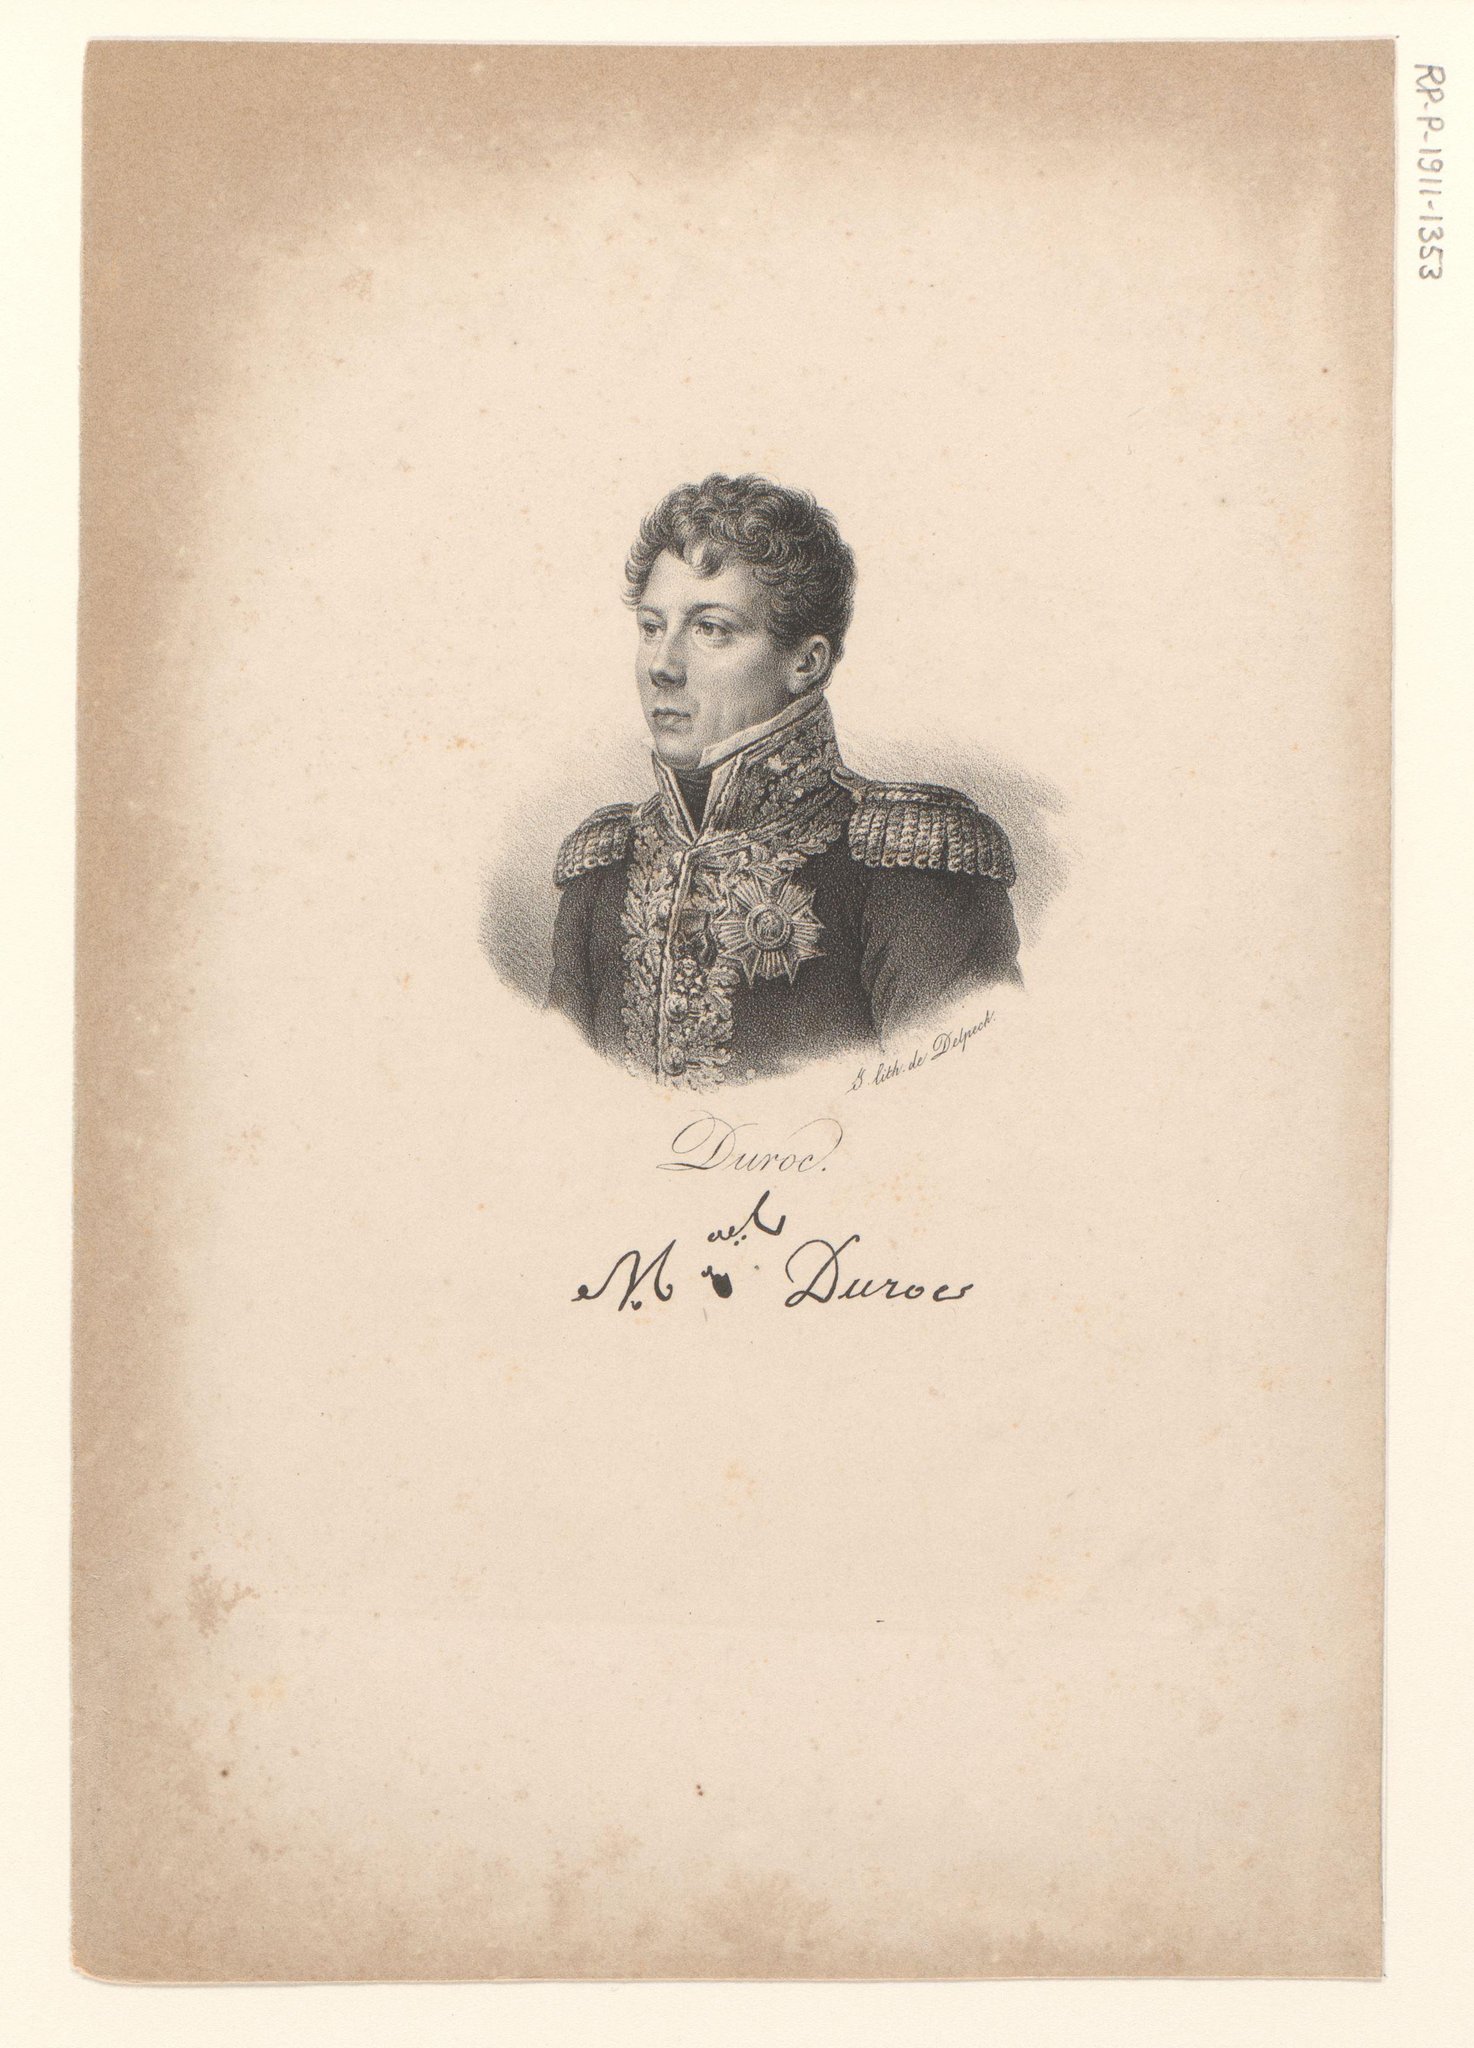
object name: print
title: Portret van Géraud Christophe Michel Duroc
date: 1818-1842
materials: paper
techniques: lithograph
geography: paris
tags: historical persons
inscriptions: collector's mark: Lugt 2228a